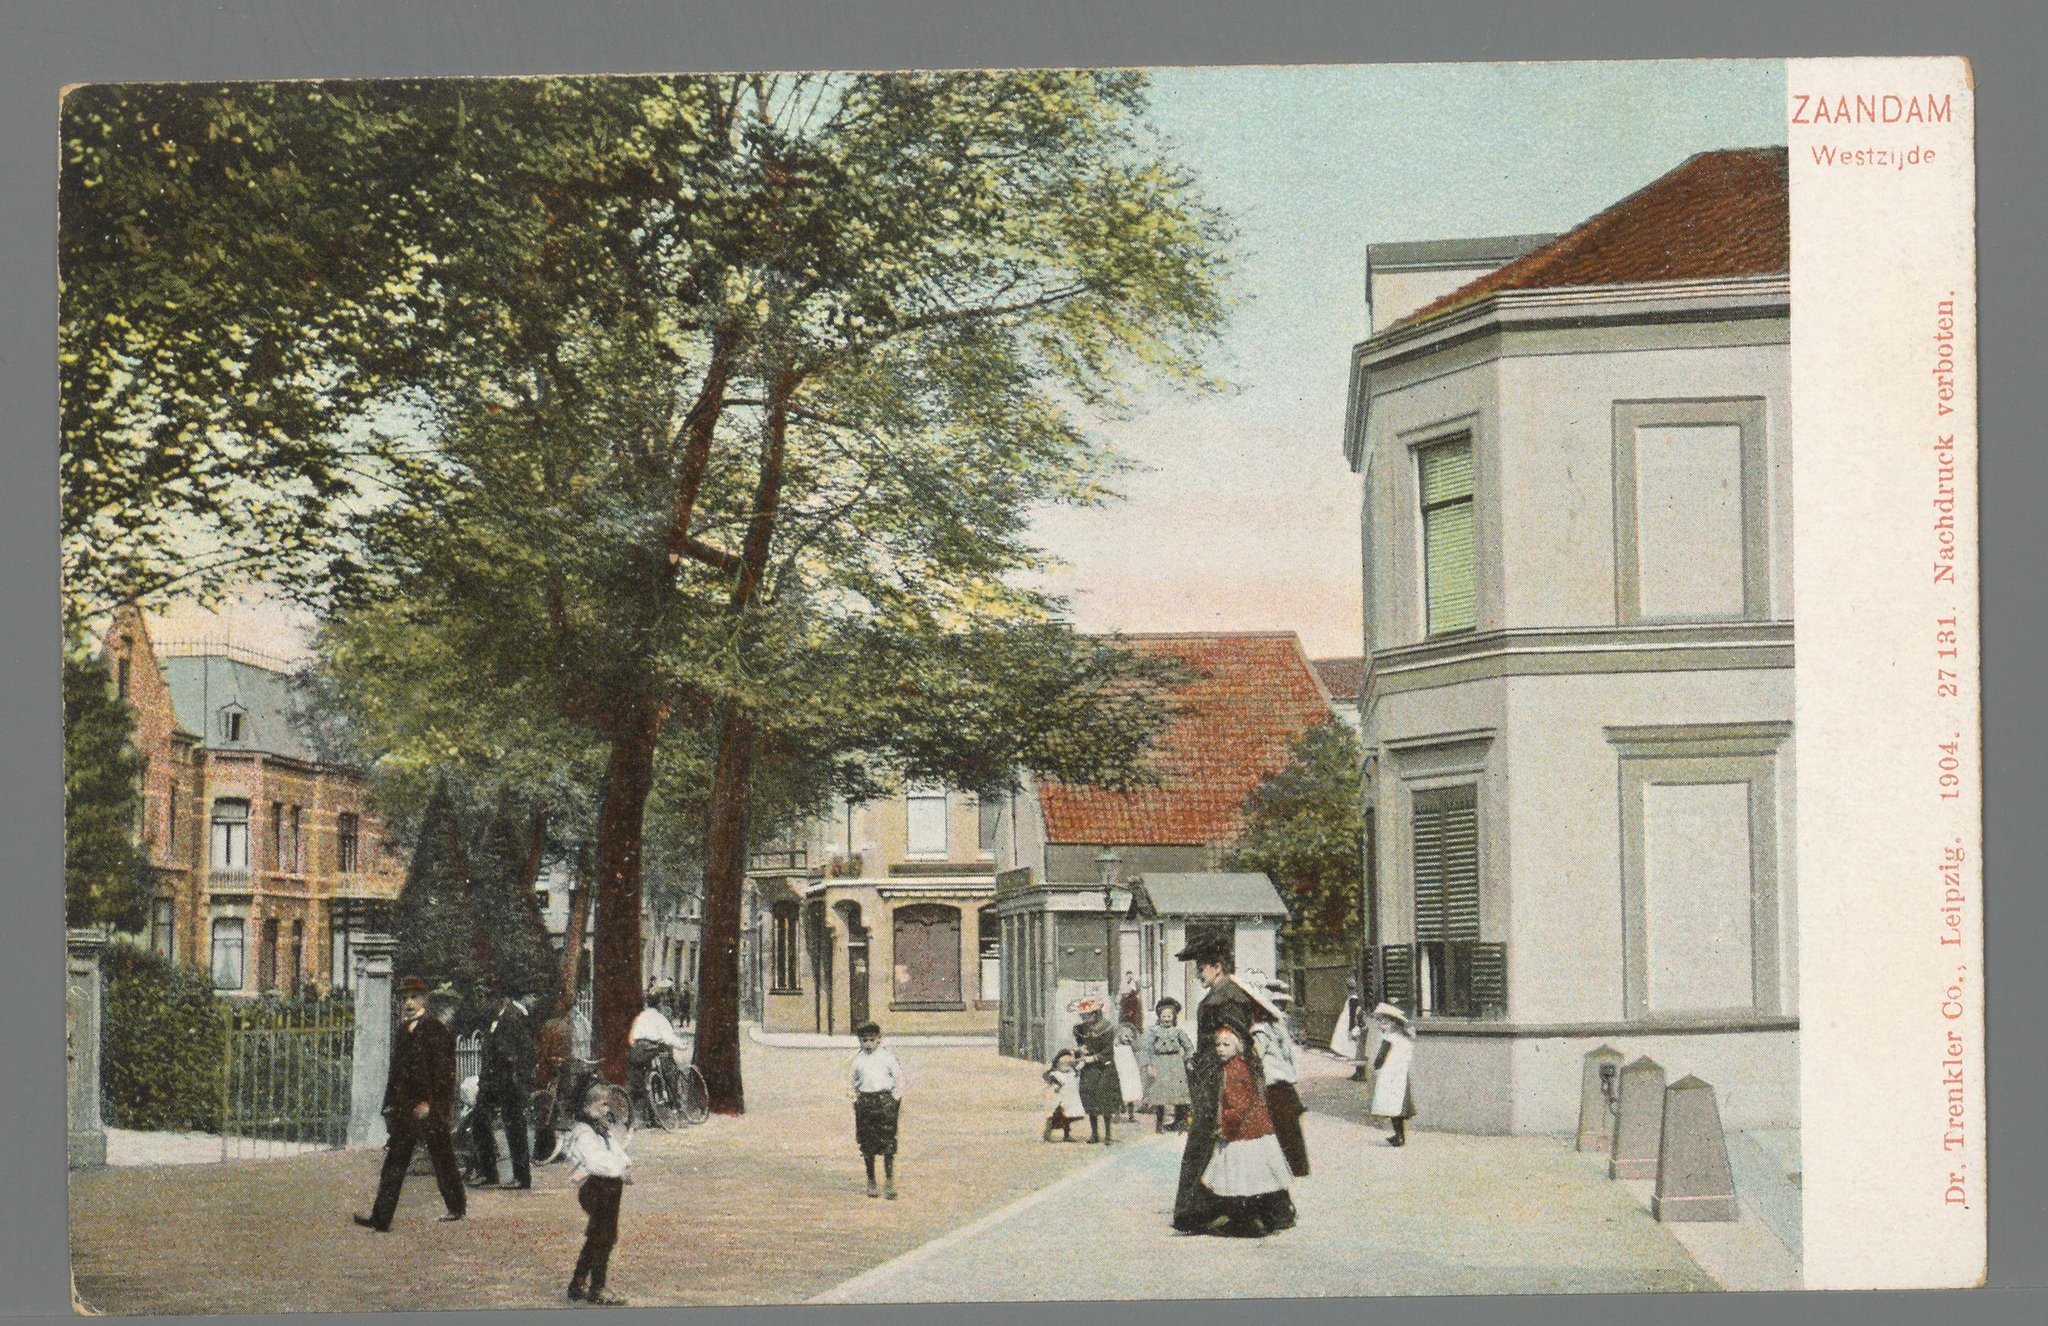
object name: photomechanical print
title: Zaandam. Westzijde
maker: Anonymous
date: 1904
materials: cardboard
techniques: lithograph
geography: leipzig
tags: city-view, and landscape with man-made constructions, street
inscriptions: date